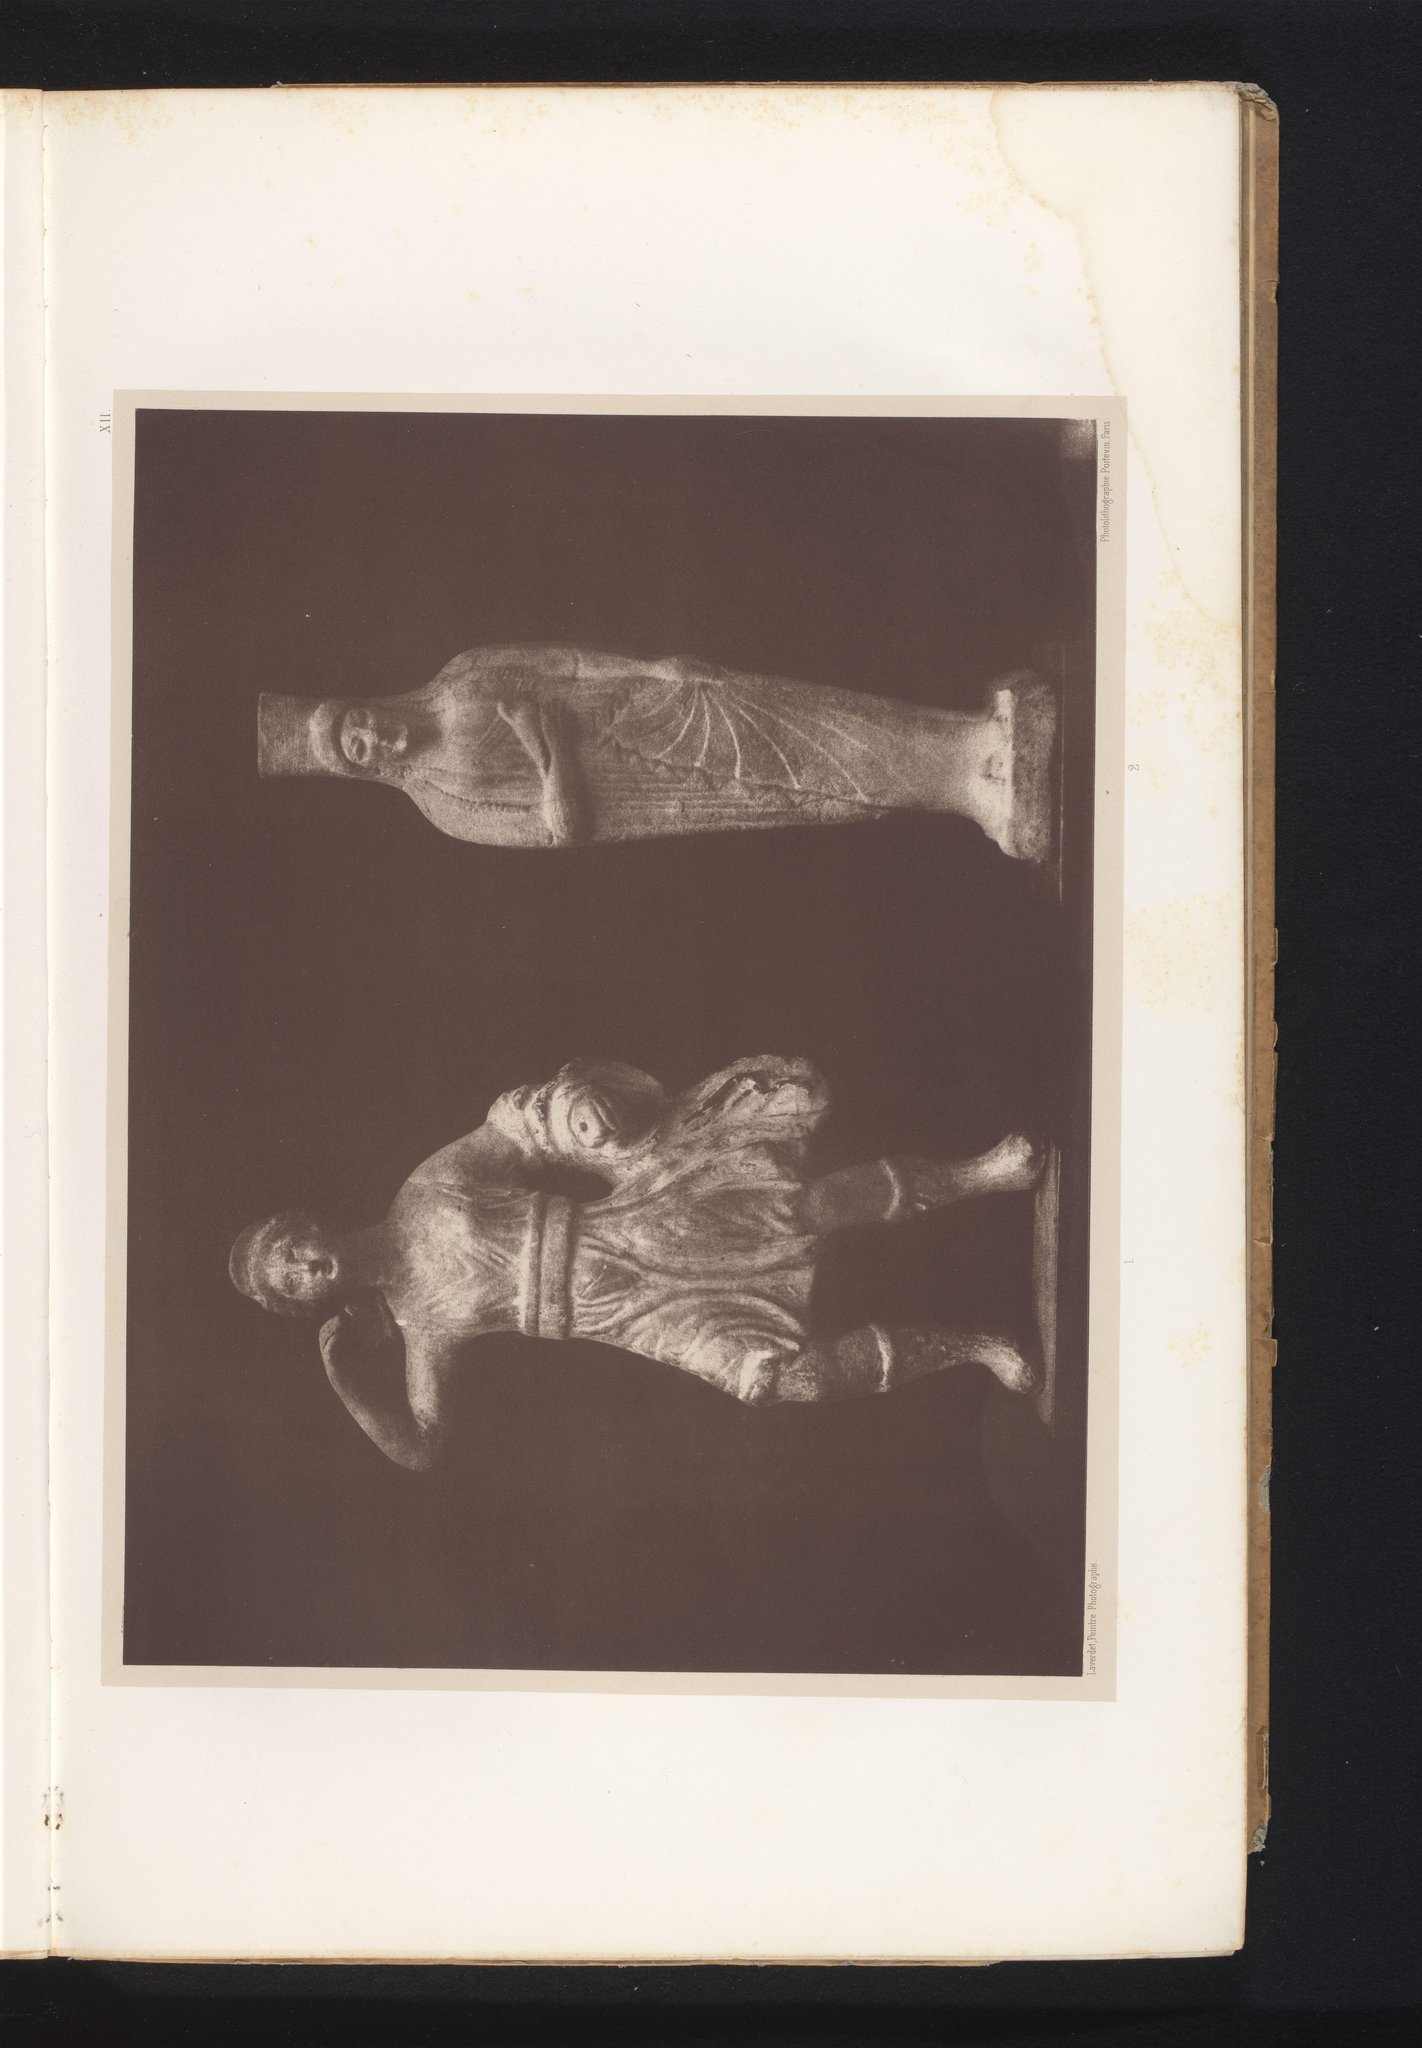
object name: page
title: Twee terracotta sculpturen van Diana en Proserpina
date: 1852-1857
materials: paper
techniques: photolithography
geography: paris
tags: (story of) proserpina (persephone, core), libera, (story of) diana (artemis), piece of sculpture, reproduction of a piece of sculpture (+ clay, sand, etc. ~ arts)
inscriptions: number: ‘1. 2.’, number: ‘XII.’